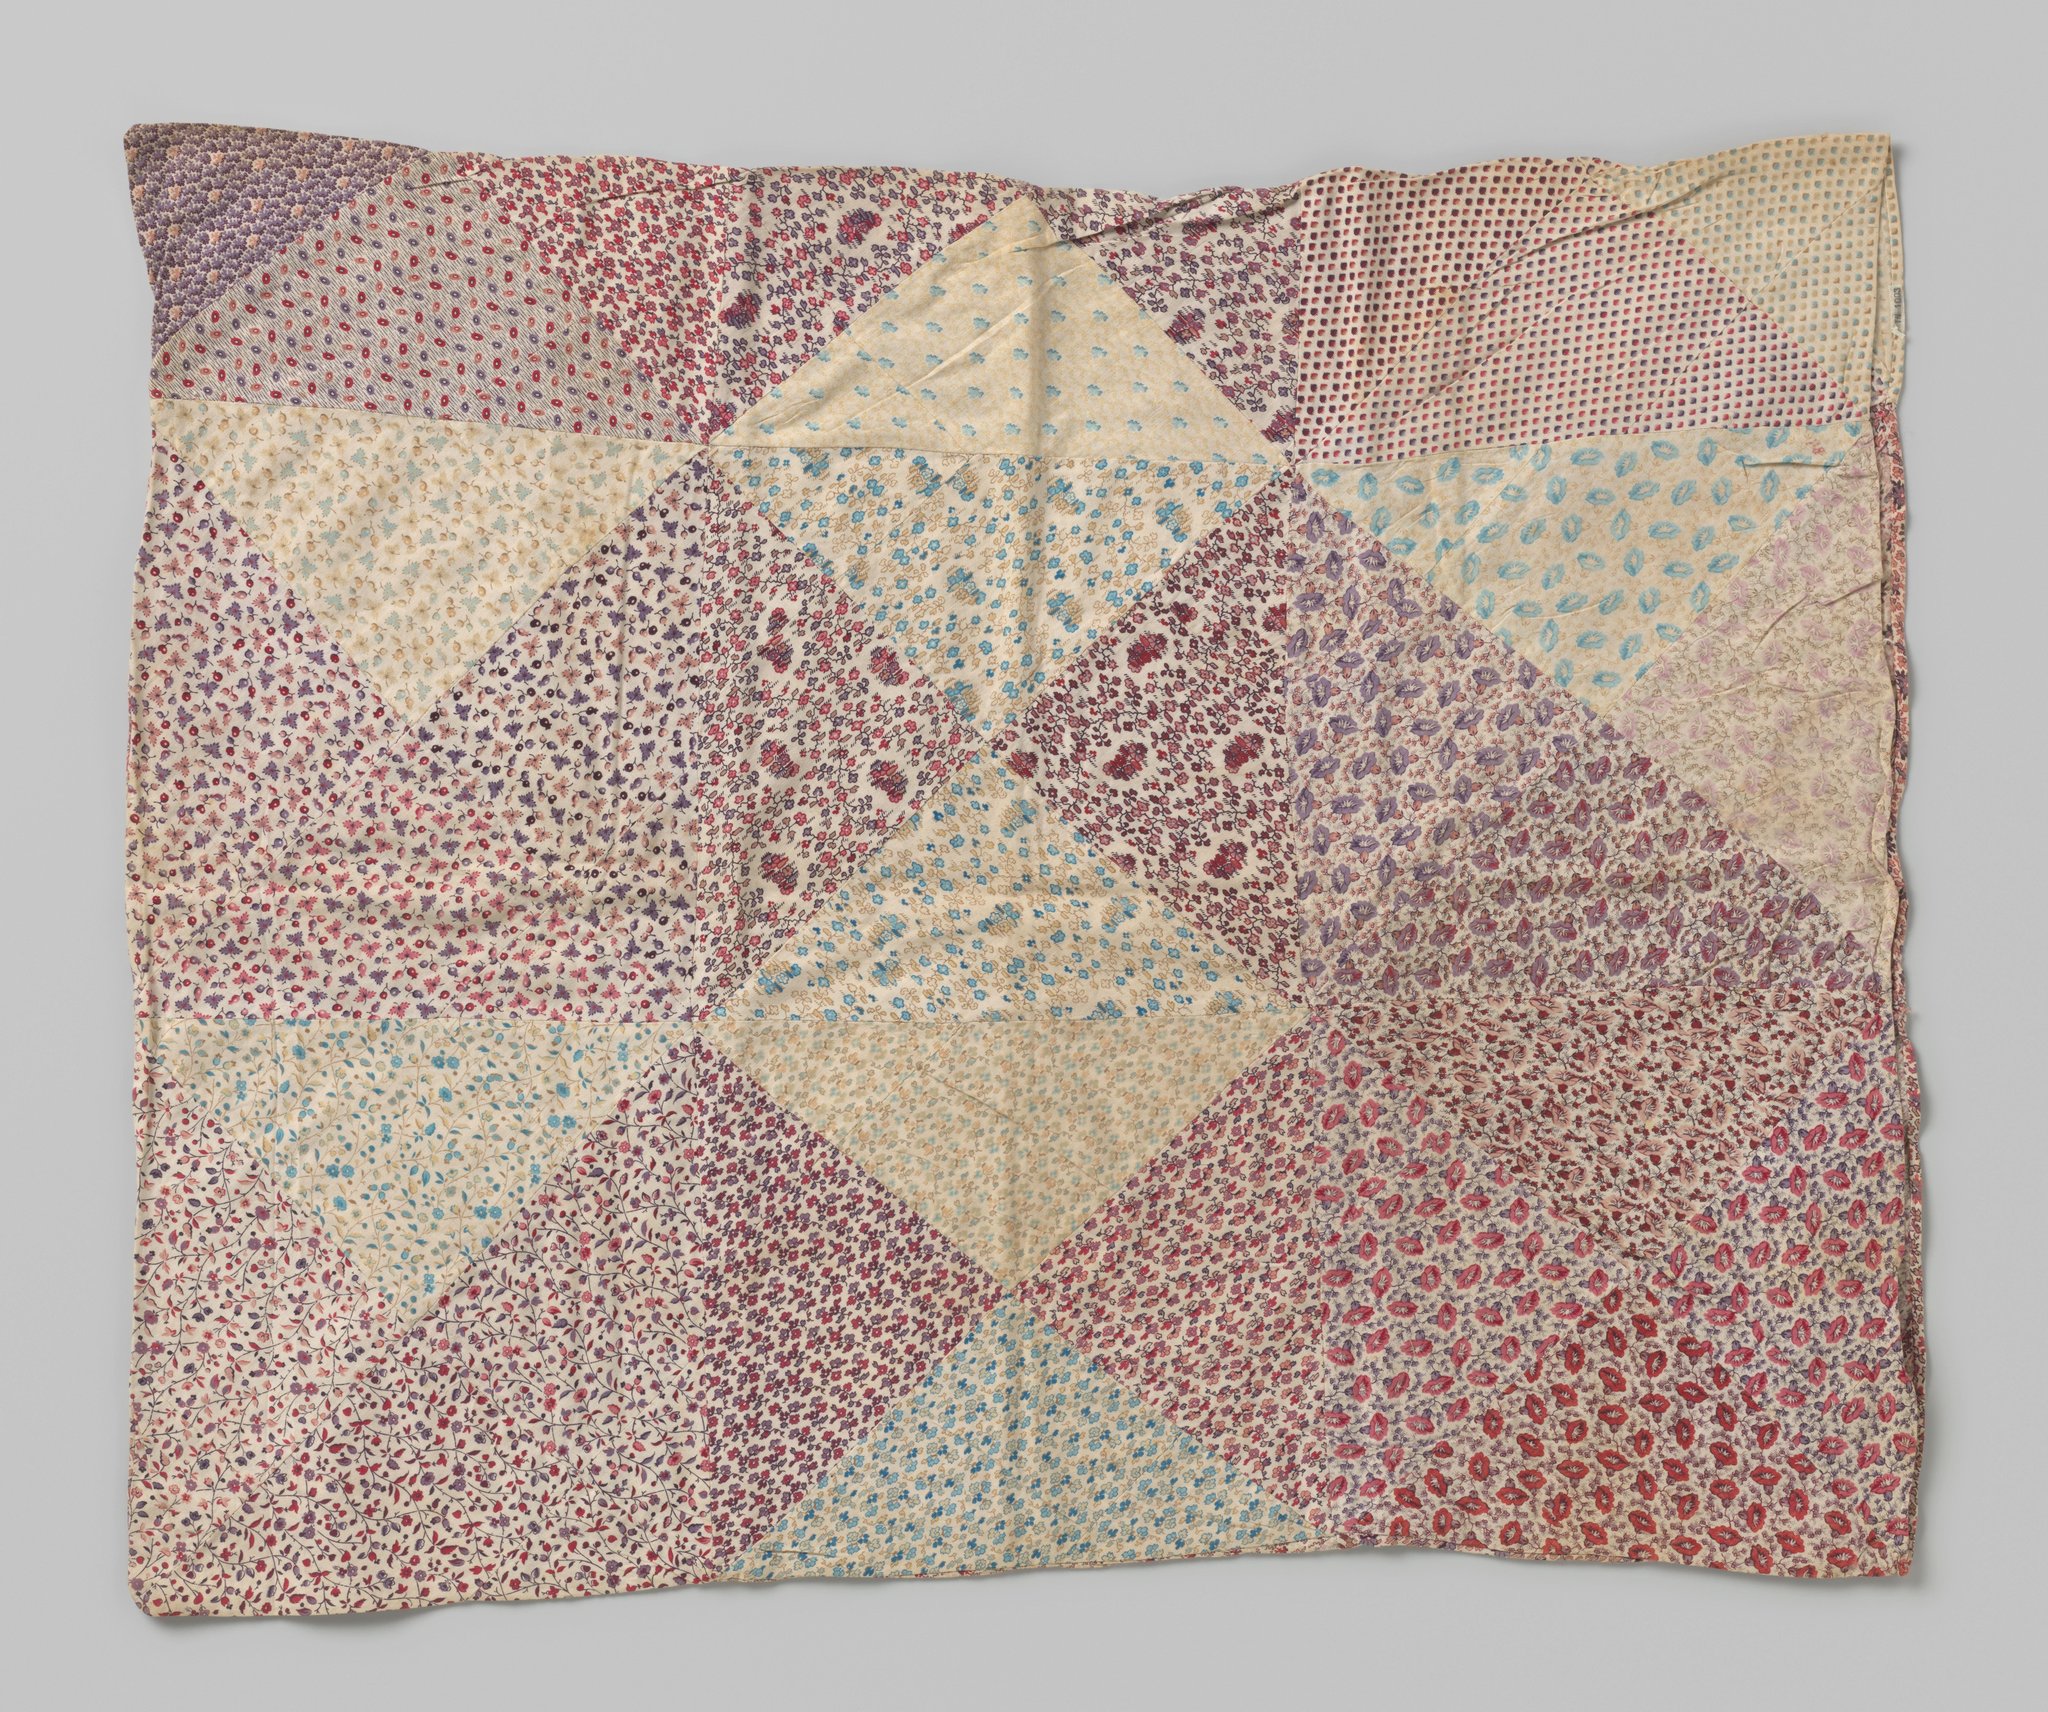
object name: bed covering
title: Sloop of matrastijk van bedrukte driehoekige lappen van katoen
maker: Anonymous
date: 1825-1850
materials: cotton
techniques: printing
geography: friesland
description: Kussensloop van aan elkaar genaaide driehoeken met verschillende bloempatronen in de kleuren roze, blauw, geel en paars.